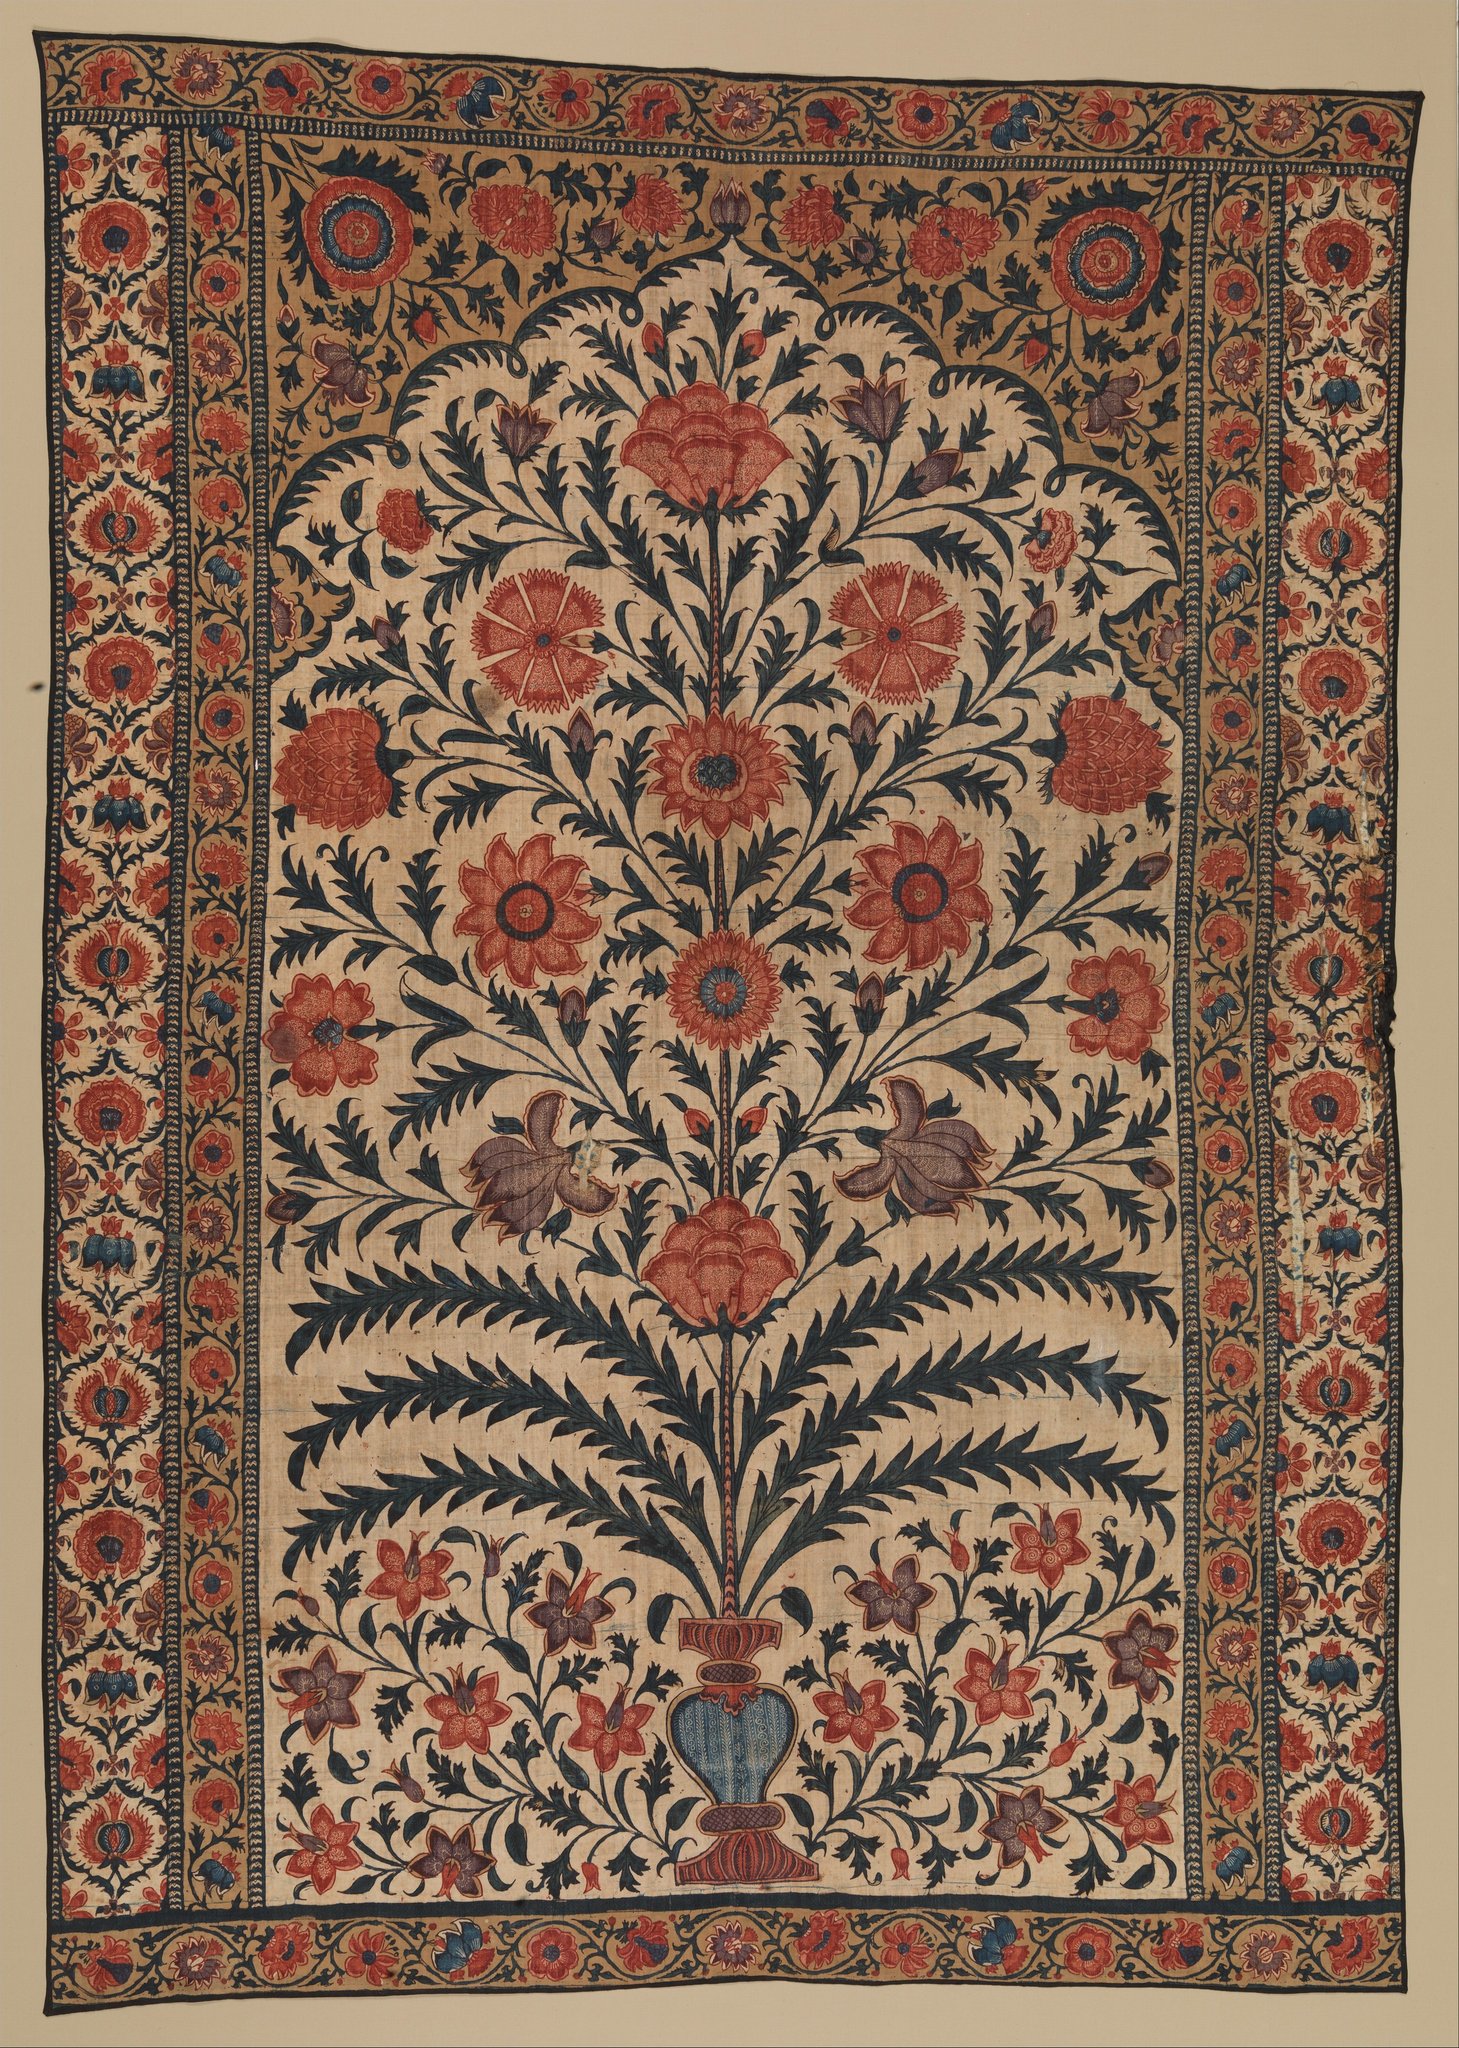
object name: tent panel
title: Panel from a Tent Lining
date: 1725-1750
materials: cotton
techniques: dyeing, painting, weave, resist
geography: india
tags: flowers